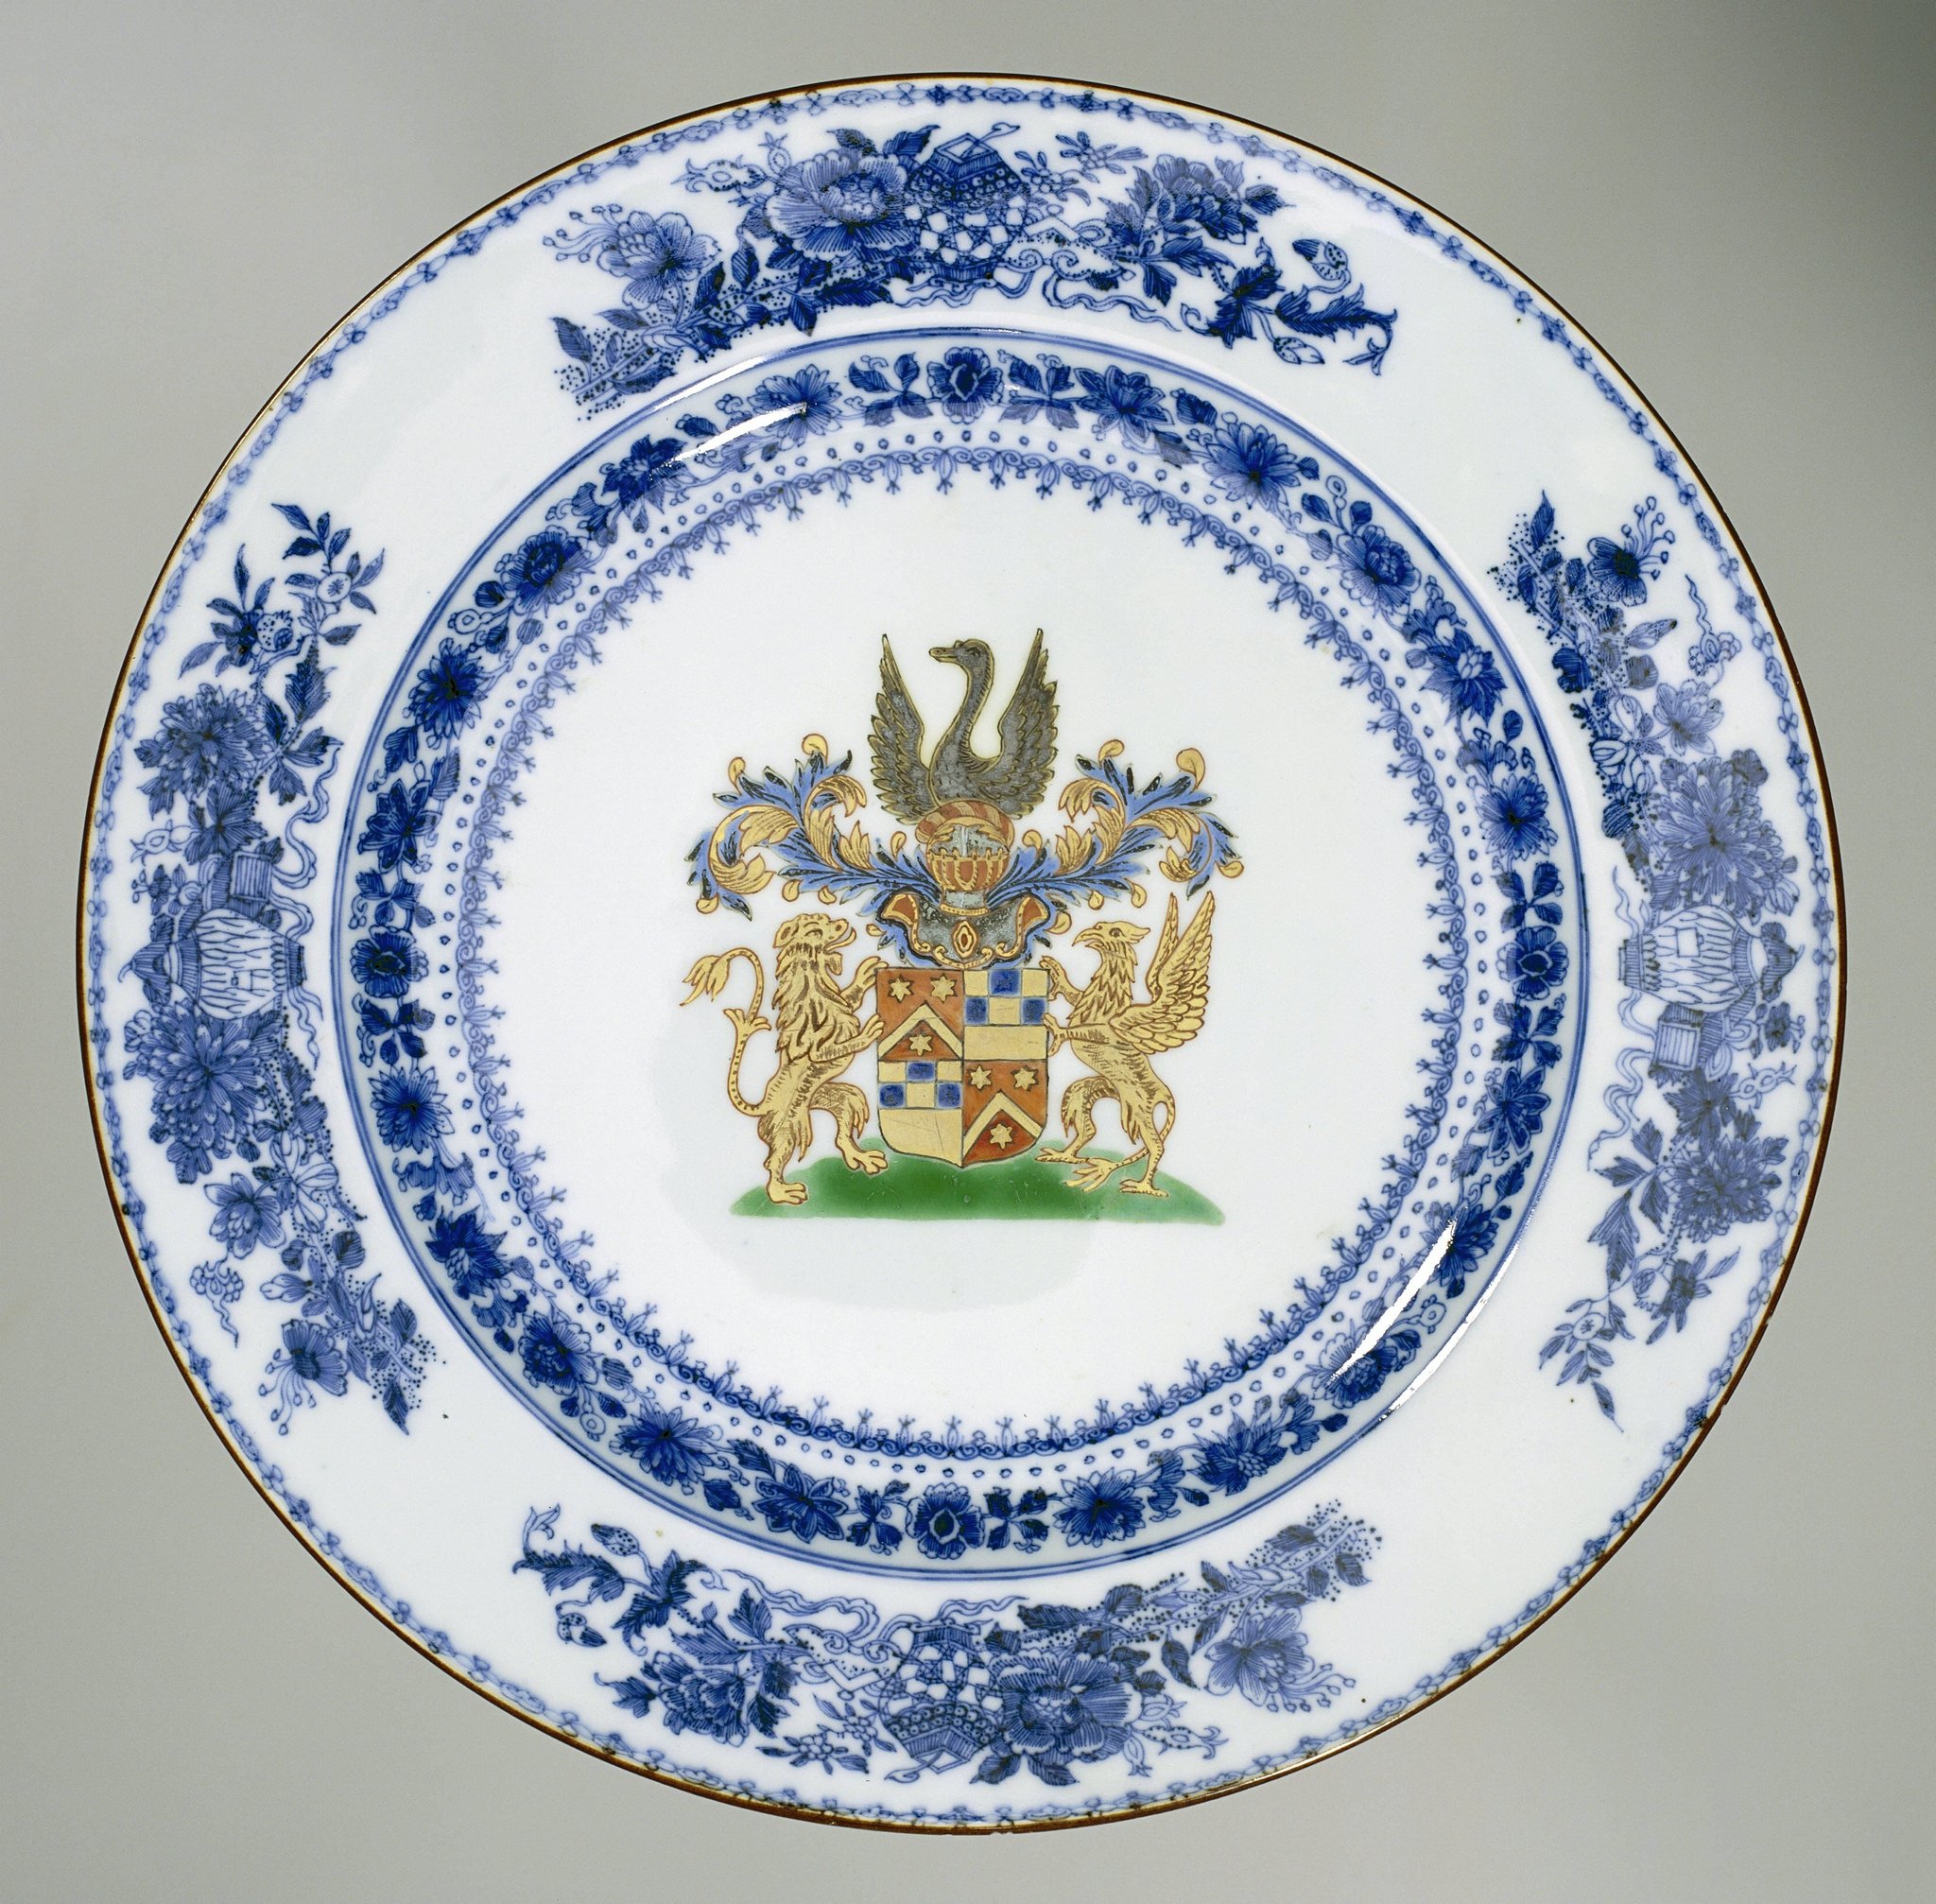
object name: plate dish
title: Plate with the arms of the De Jonge family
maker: Anonymous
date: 1730-1740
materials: glaze, gold, paint, porcelain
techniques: firing, gilding, turning, vitrification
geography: china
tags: batavia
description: In het plat het wapen van de familie de Jonge verdeeld in vier vlakken in de emailkleuren ijzerrood, blauw en goud. Het wapen wordt ondersteund door een leeuw en een griffioen op een groene ondergrond. Het helmteken is een zwarte zwaan en een dekkleed van bladranken. Op de wand een band van bloemranken en (vroege) spearheads of bloemknoppen en op de achterzijde van het bord vlinders en pioenen. Op de rand vier bloemtakken met andere objecten.